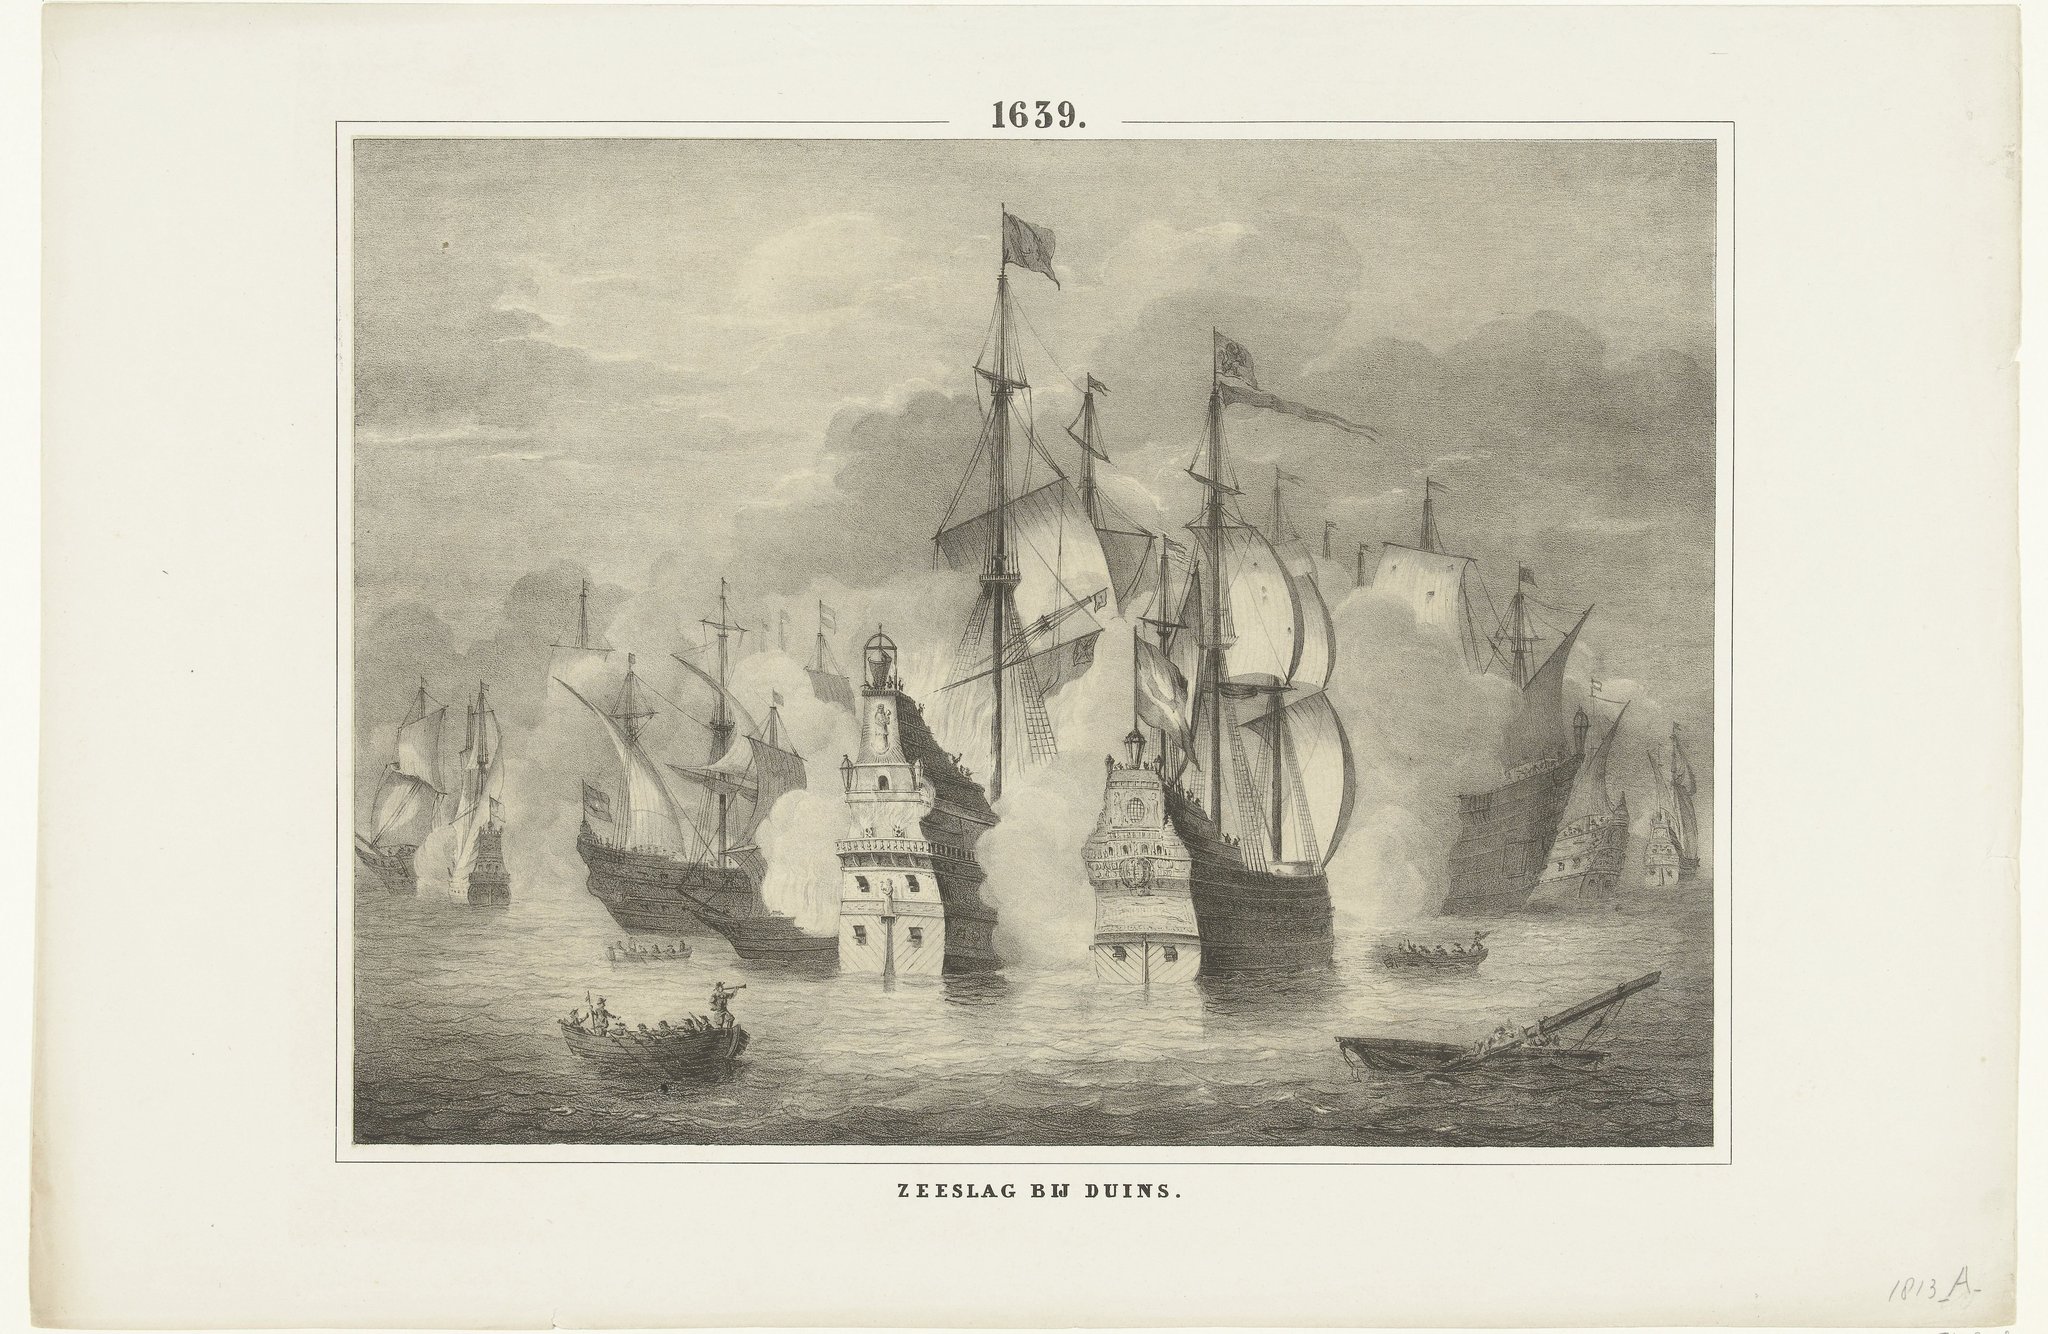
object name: history print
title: Zeeslag bij Duins, 1639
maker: Anonymous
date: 1853-1855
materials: paper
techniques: tone lithography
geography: netherlands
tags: brielle, maarten harpertszoon tromp, battle (+ naval force), battle of the downs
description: Gebruikt als illustratie in: J.H. Eichman & H. Altmann, Vaderlandsche historieplaten voor scholen en huisgezinnen, Leiden, 1855. Dit nummer is een door het RPK toegevoegd nummer en staat niet in Frederik Muller, het werk waar de prent voor is gemaakt of uit afkomstig is, staat wel vermeld in Frederik Muller. Gebaseerd op de prent van Salomon Savery naar Abraham de Verwer (FMH 1803).